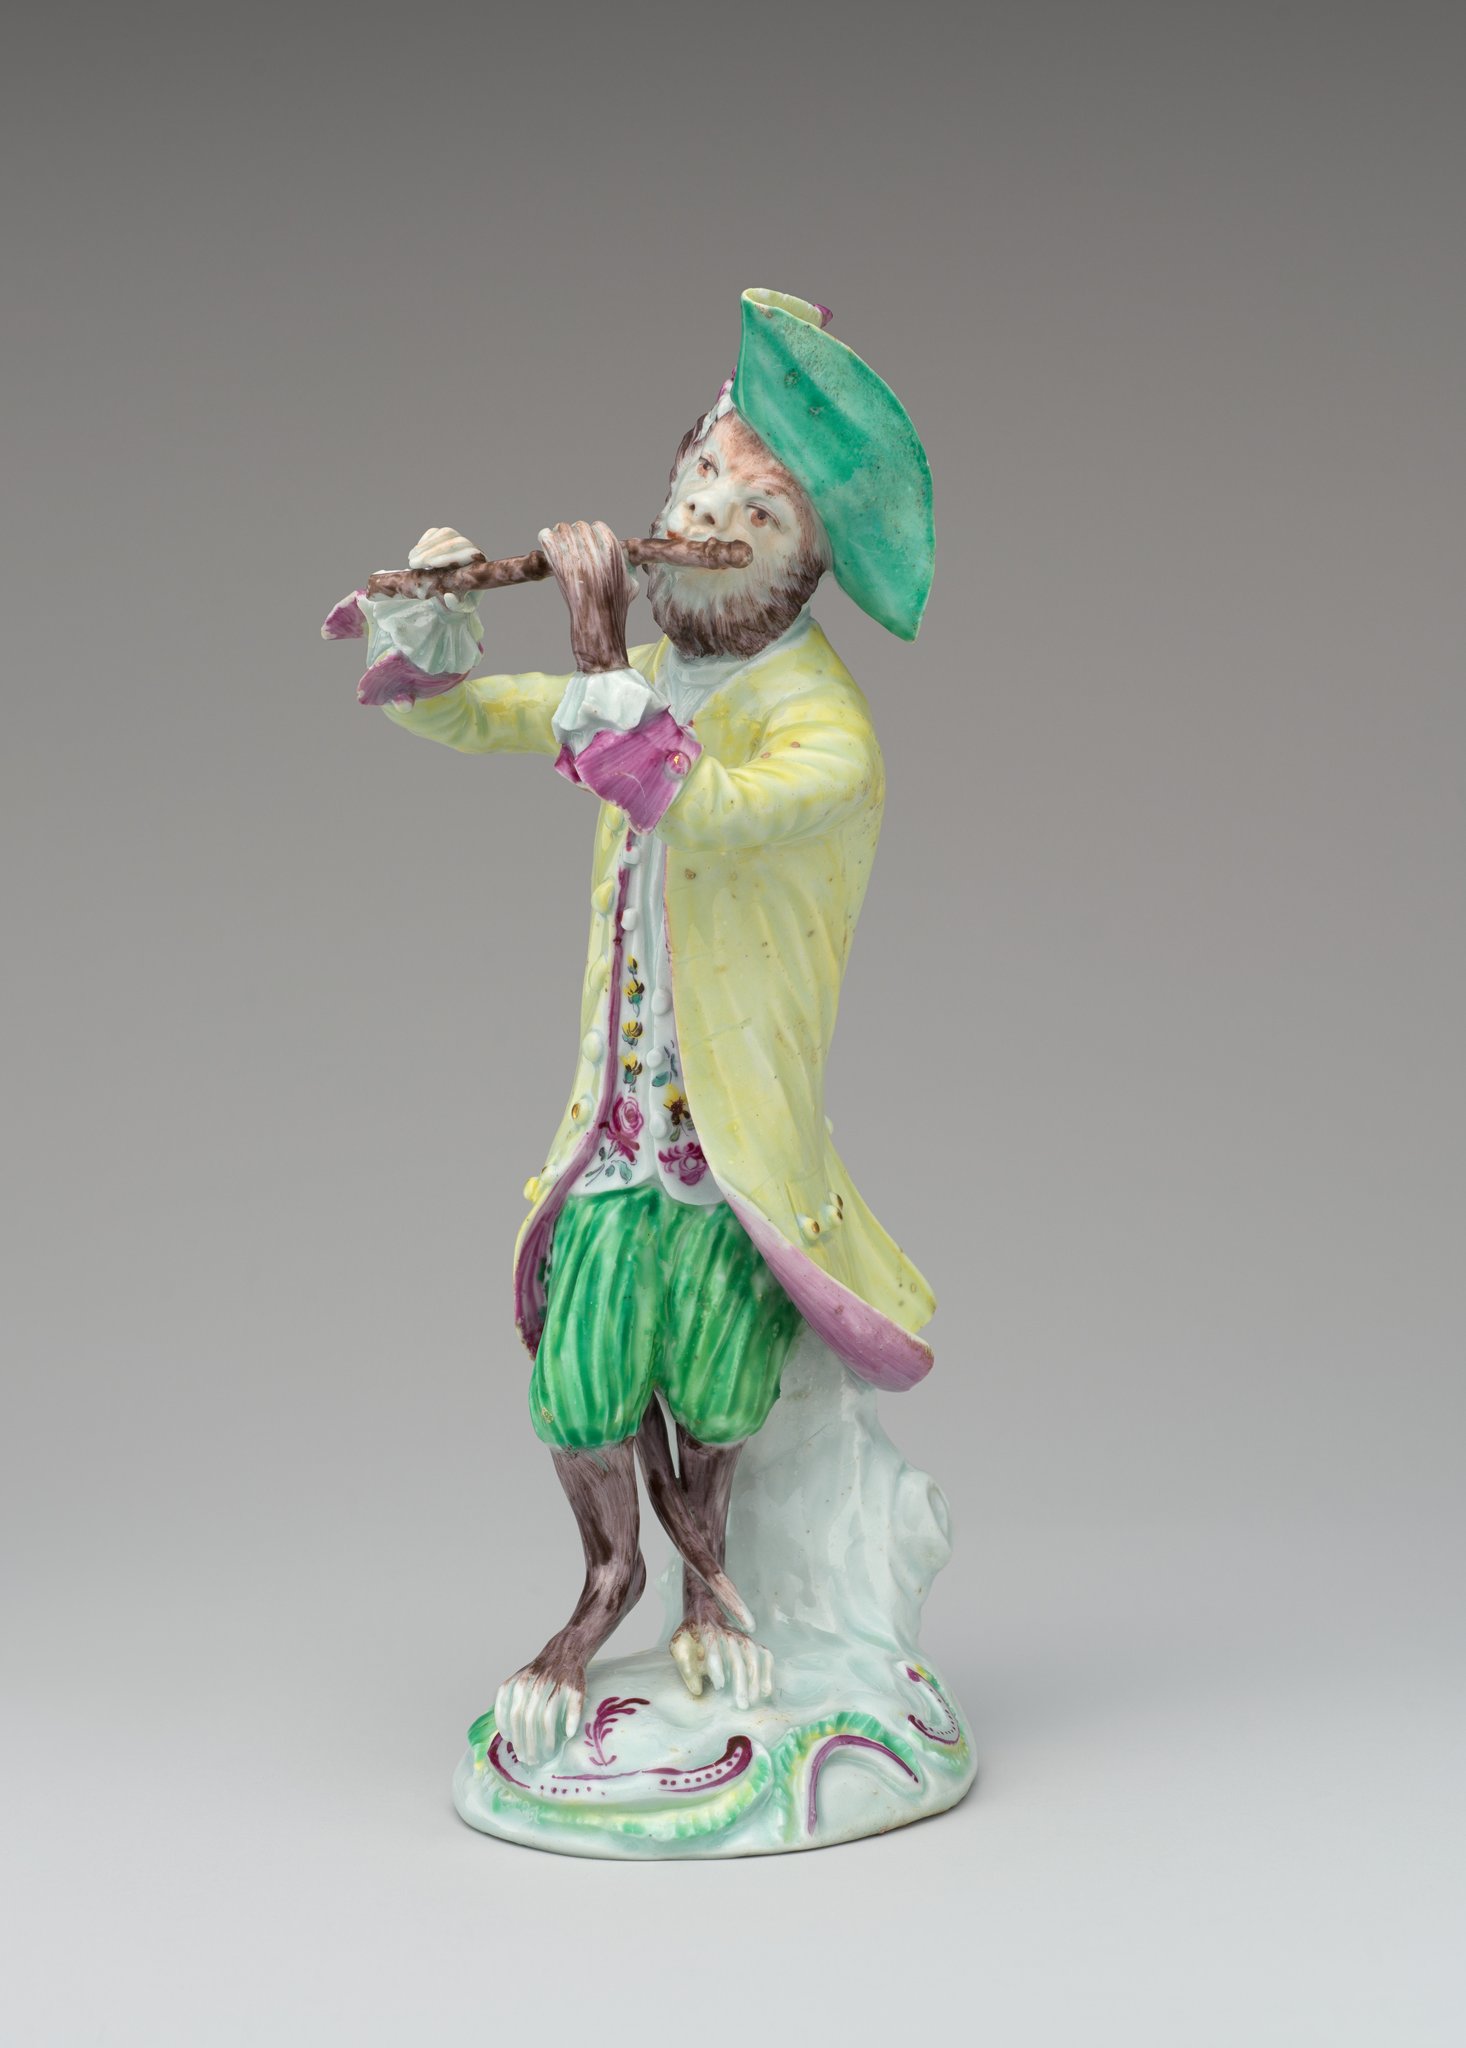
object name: figure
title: Monkey musician (part of a set)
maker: derby porcelain manufactory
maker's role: factory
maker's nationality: british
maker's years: 1751-1785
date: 1760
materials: soft paste porcelain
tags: flutes,monkeys,musicians